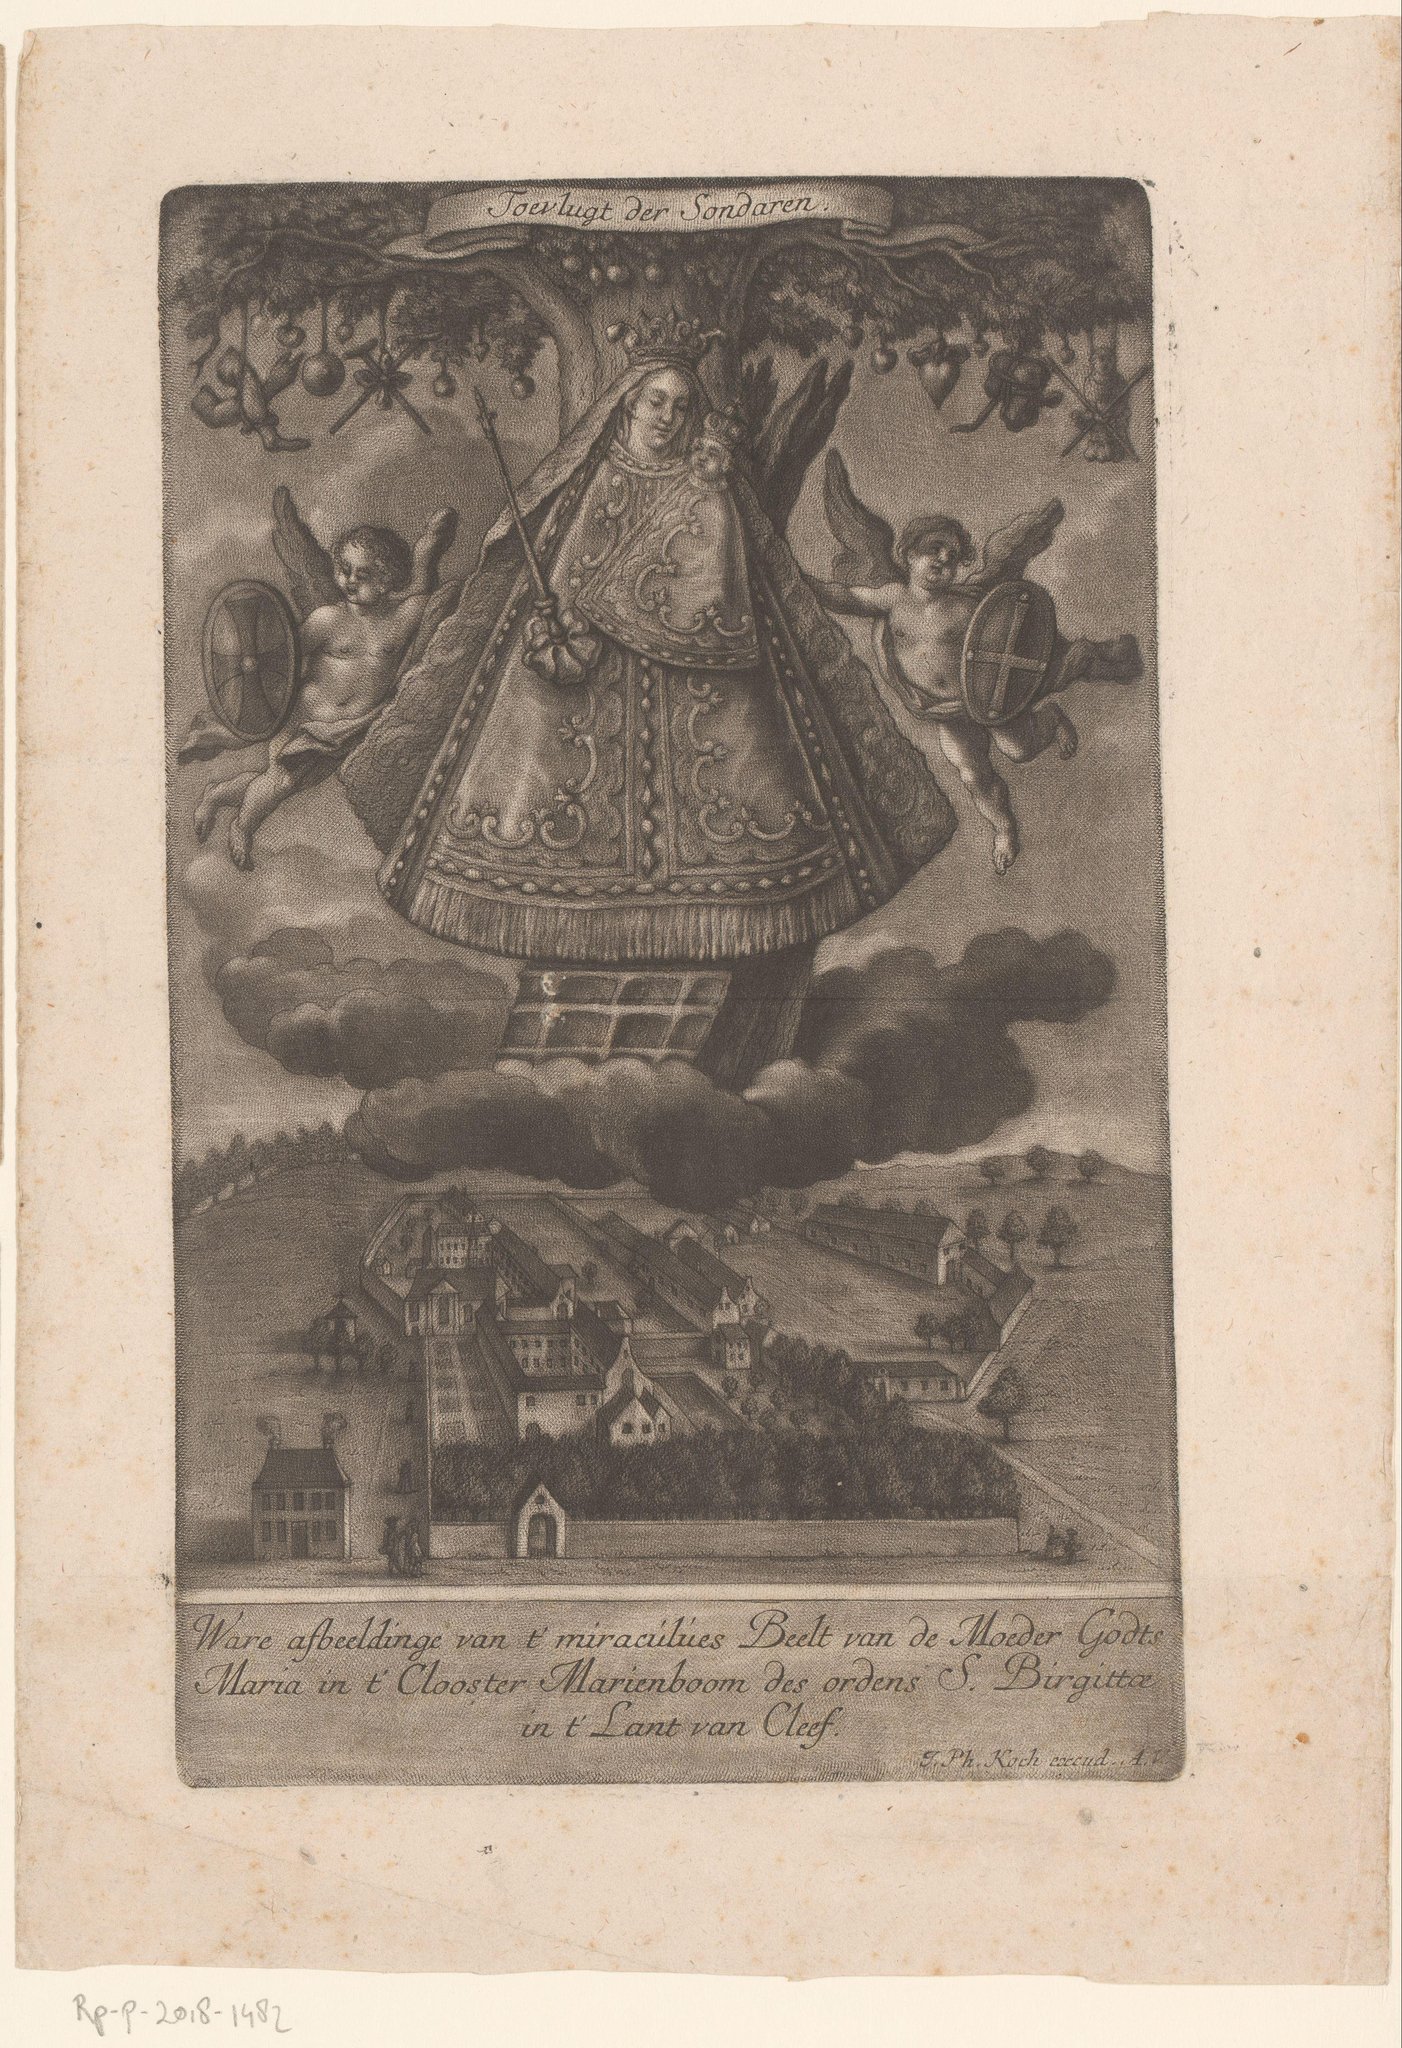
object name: print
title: Toevlucht der sondaren / Ware afbeeldinge van t' miraculues beelt van de Moeder Godts Maria in t' clooster Marienboom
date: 1650-1749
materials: paper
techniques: mezzotint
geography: augsburg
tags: mary standing (or half-length), the christ-child lying on her arm (christ-child to mary's left), trees: oak, cloisters ~ monastery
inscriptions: collector's mark: Lugt 2228